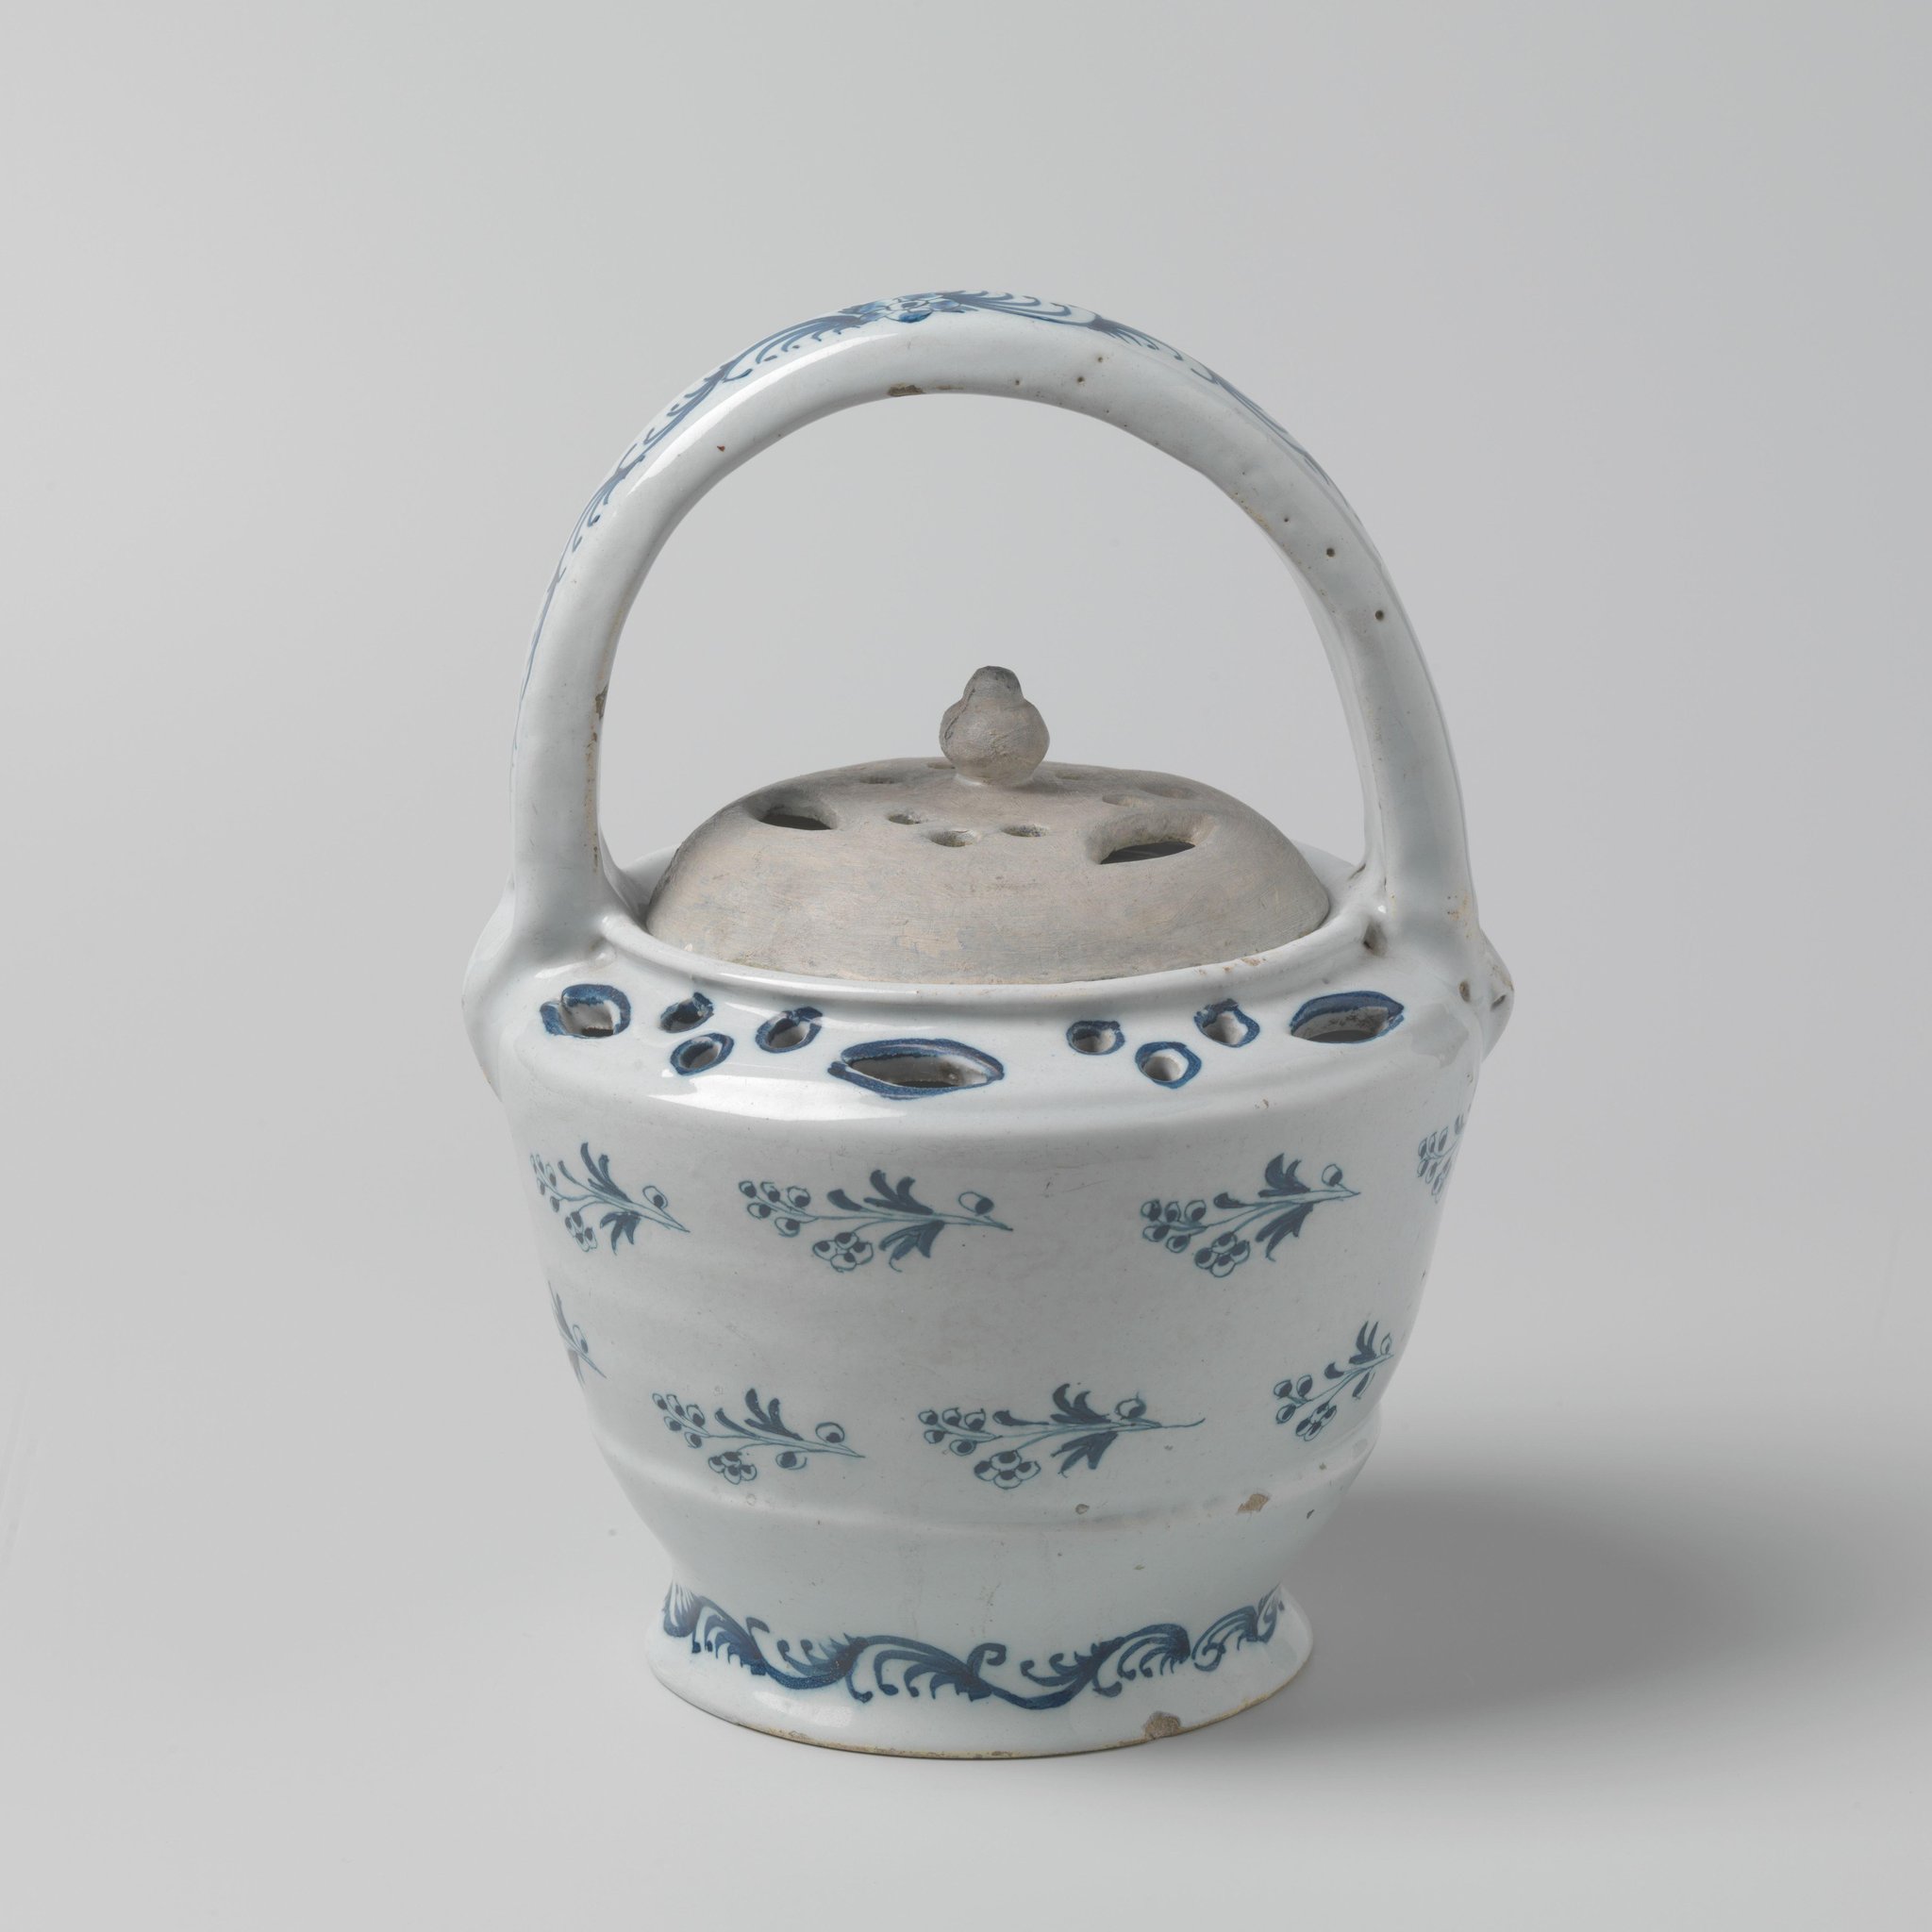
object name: tureen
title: Deksel van terrine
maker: Anonymous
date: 1775-1820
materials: faience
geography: brussels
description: Deksel van terrine van faience. Niet origineel.